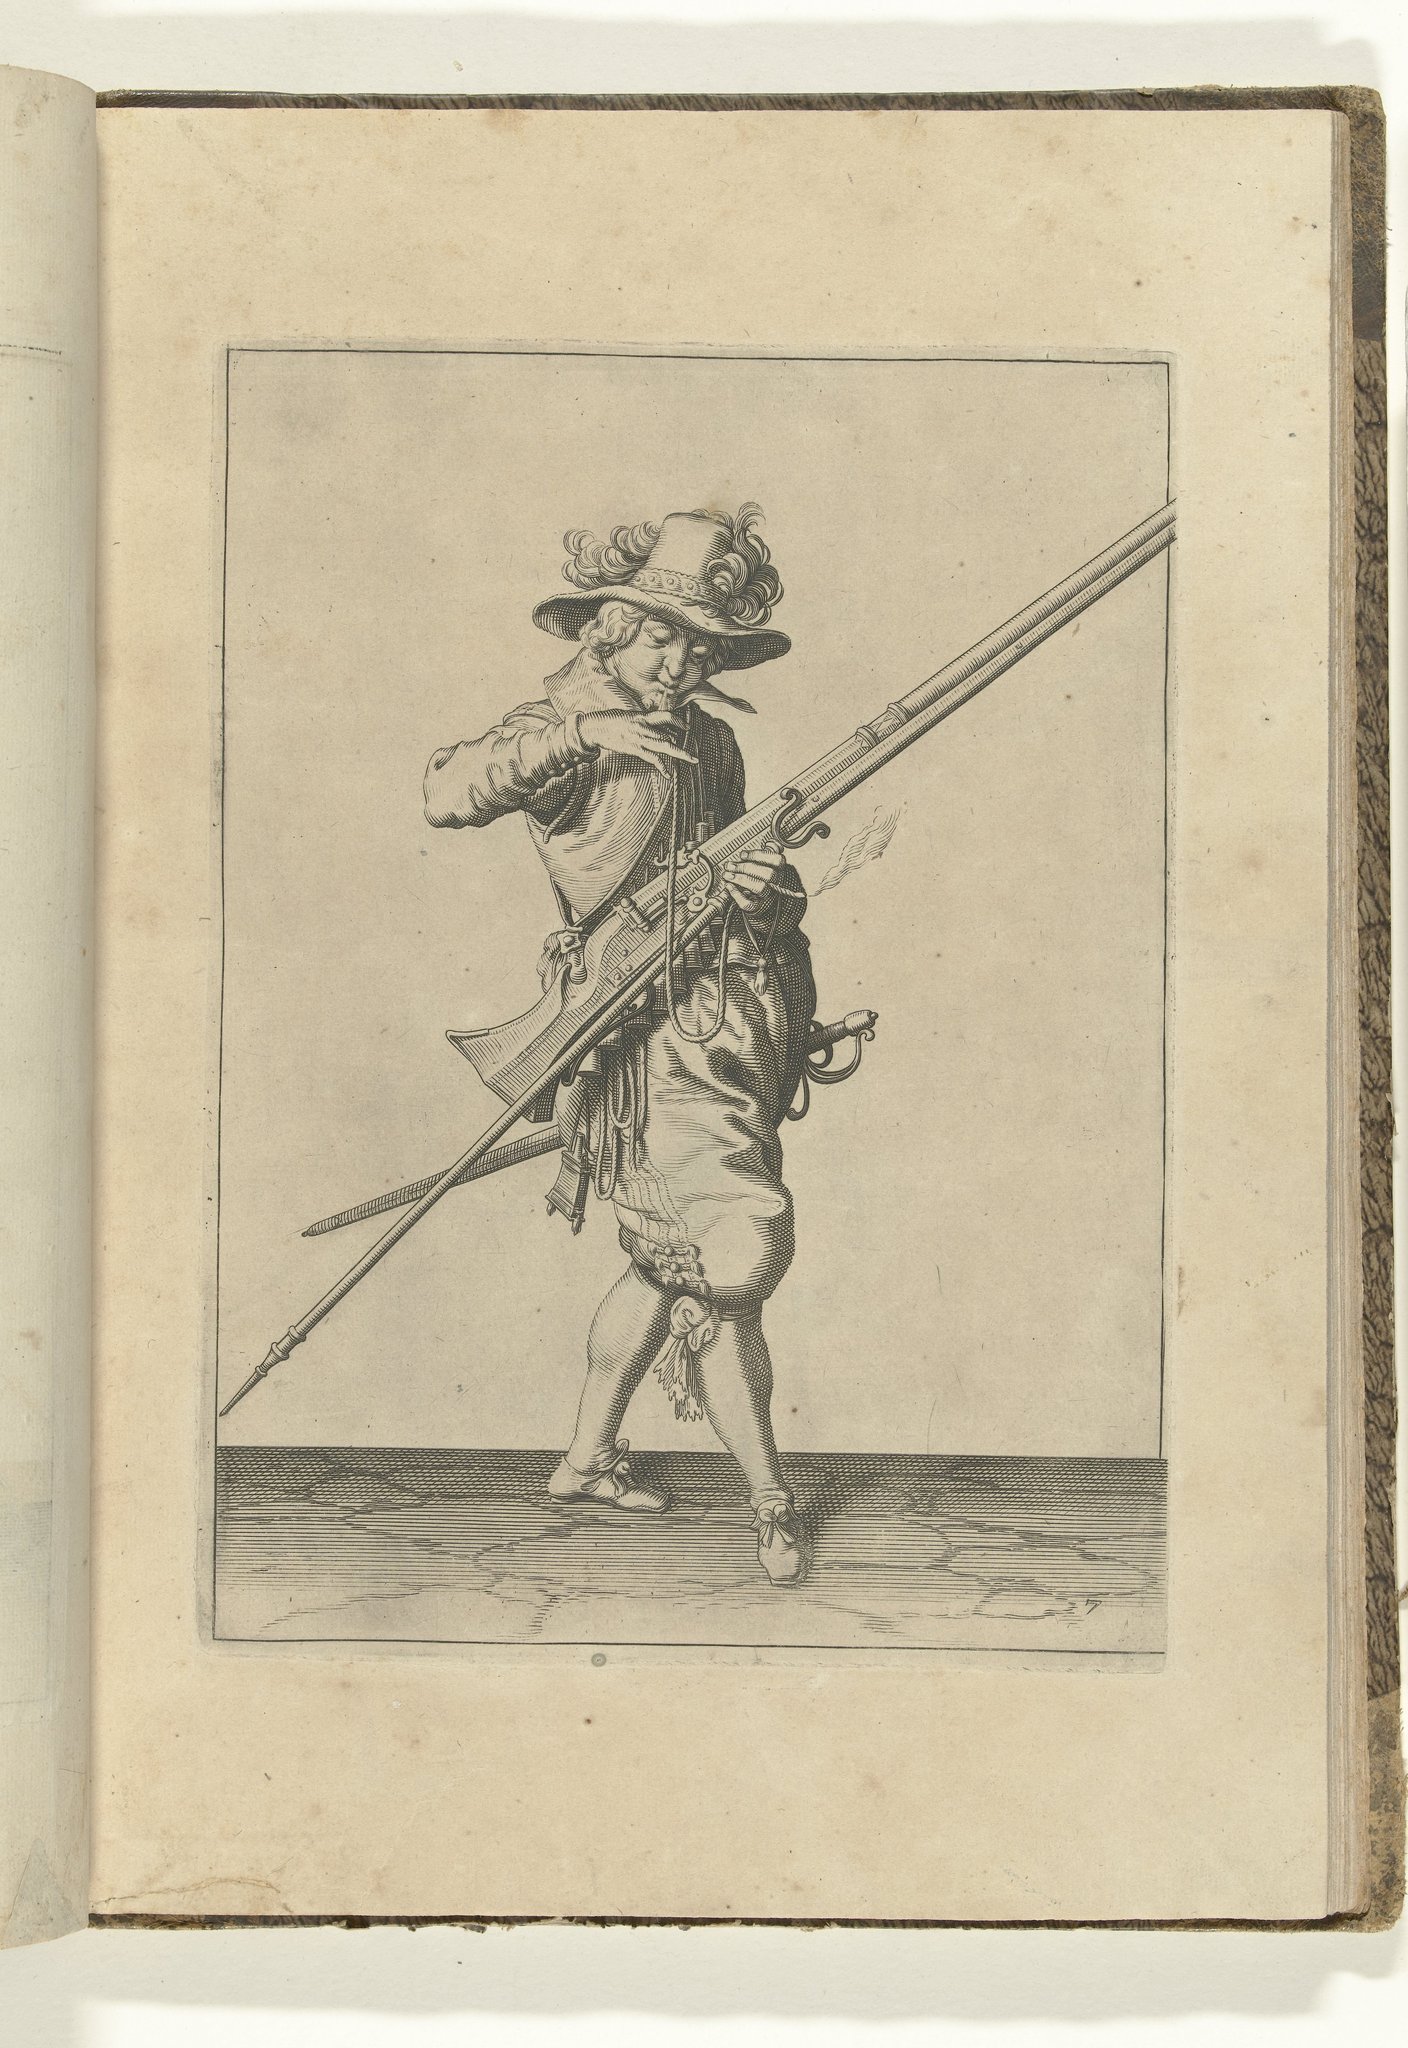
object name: print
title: Soldaat met een musket die zijn lont naar zijn mond brengt om hem schoon te blazen (nr. 7), ca. 1600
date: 1597-1608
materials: paper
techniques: engraving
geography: northern netherlands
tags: maurice (prince of orange), handling of weapons ~ military training, weapons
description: Een soldaat, ten voeten uit, naar rechts, die een musket (een bepaald type vuurwapen) met zijn linkerhand vasthoudt (nr. 7), ca. 1600. Met zijn rechterhand brengt hij een brandende lont naar zijn mond om hem schoon te blazen. Plaat 7 in de instructies voor het hanteren van het musket: Brief enseignement, sur les pourtraitz figurez, touchant le droit maniement du Mousquet. Onderdeel van de illustraties in een Franse editie van J. de Gheyns Wapenhandelinghe: J. de Gheyn, Maniement d'armes, d'arquebuses, mousquetz et piques : en conformité de l'ordre de Mour le Prince Maurice, Prince d'Orange, Amsterdam 1608. Krijgswezen rond 1600.